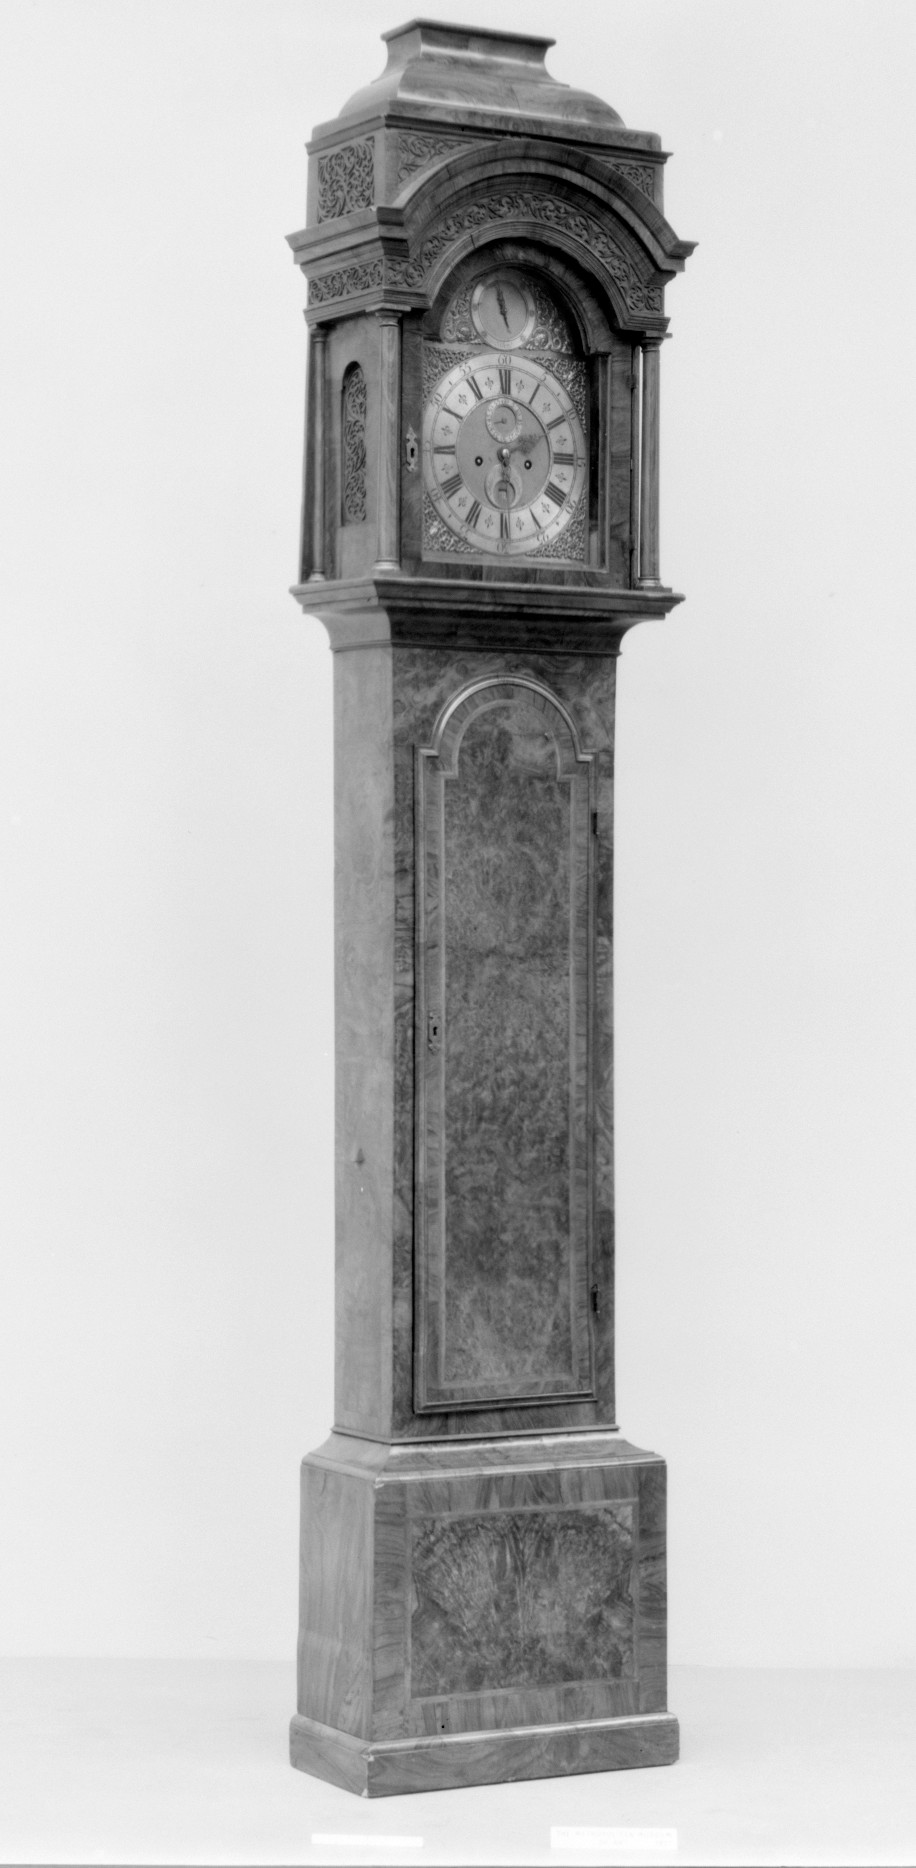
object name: longcase clock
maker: john ellicott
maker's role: maker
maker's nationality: british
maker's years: 1706-1772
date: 1730-1740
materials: wood